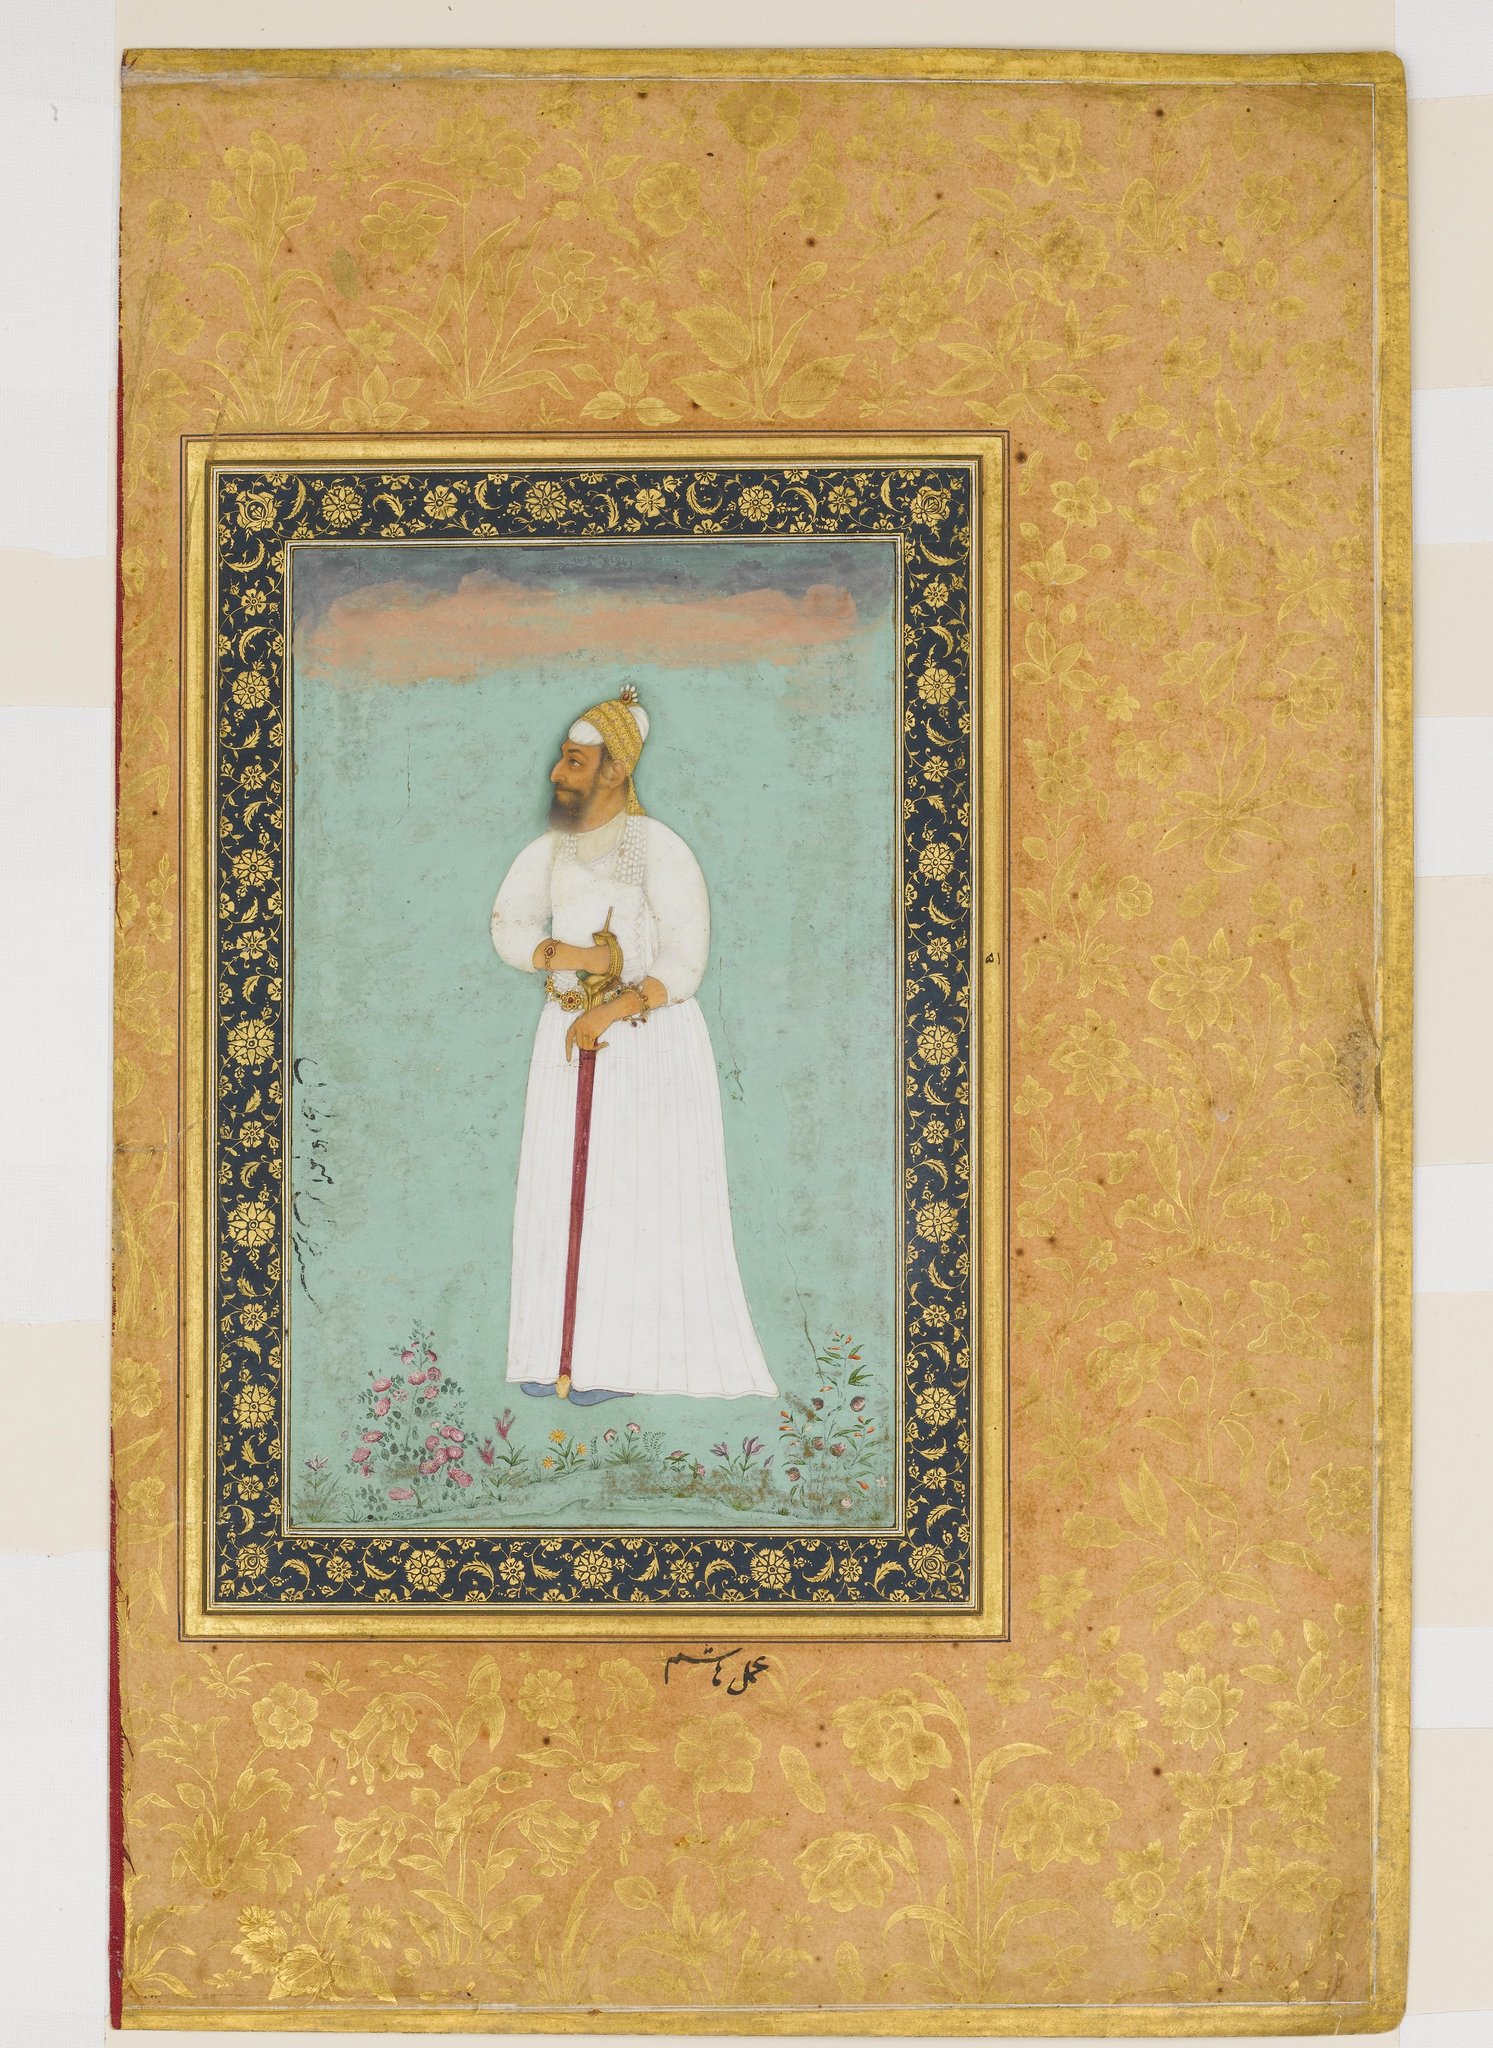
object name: album leaf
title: "Portrait of Ibrahim 'Adil Shah II of Bijapur", Folio from the Shah Jahan Album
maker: hashim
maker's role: artist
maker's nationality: indian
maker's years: 1595-1685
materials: gold, ink, paper, watercolor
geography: india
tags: swords,kings,portraits